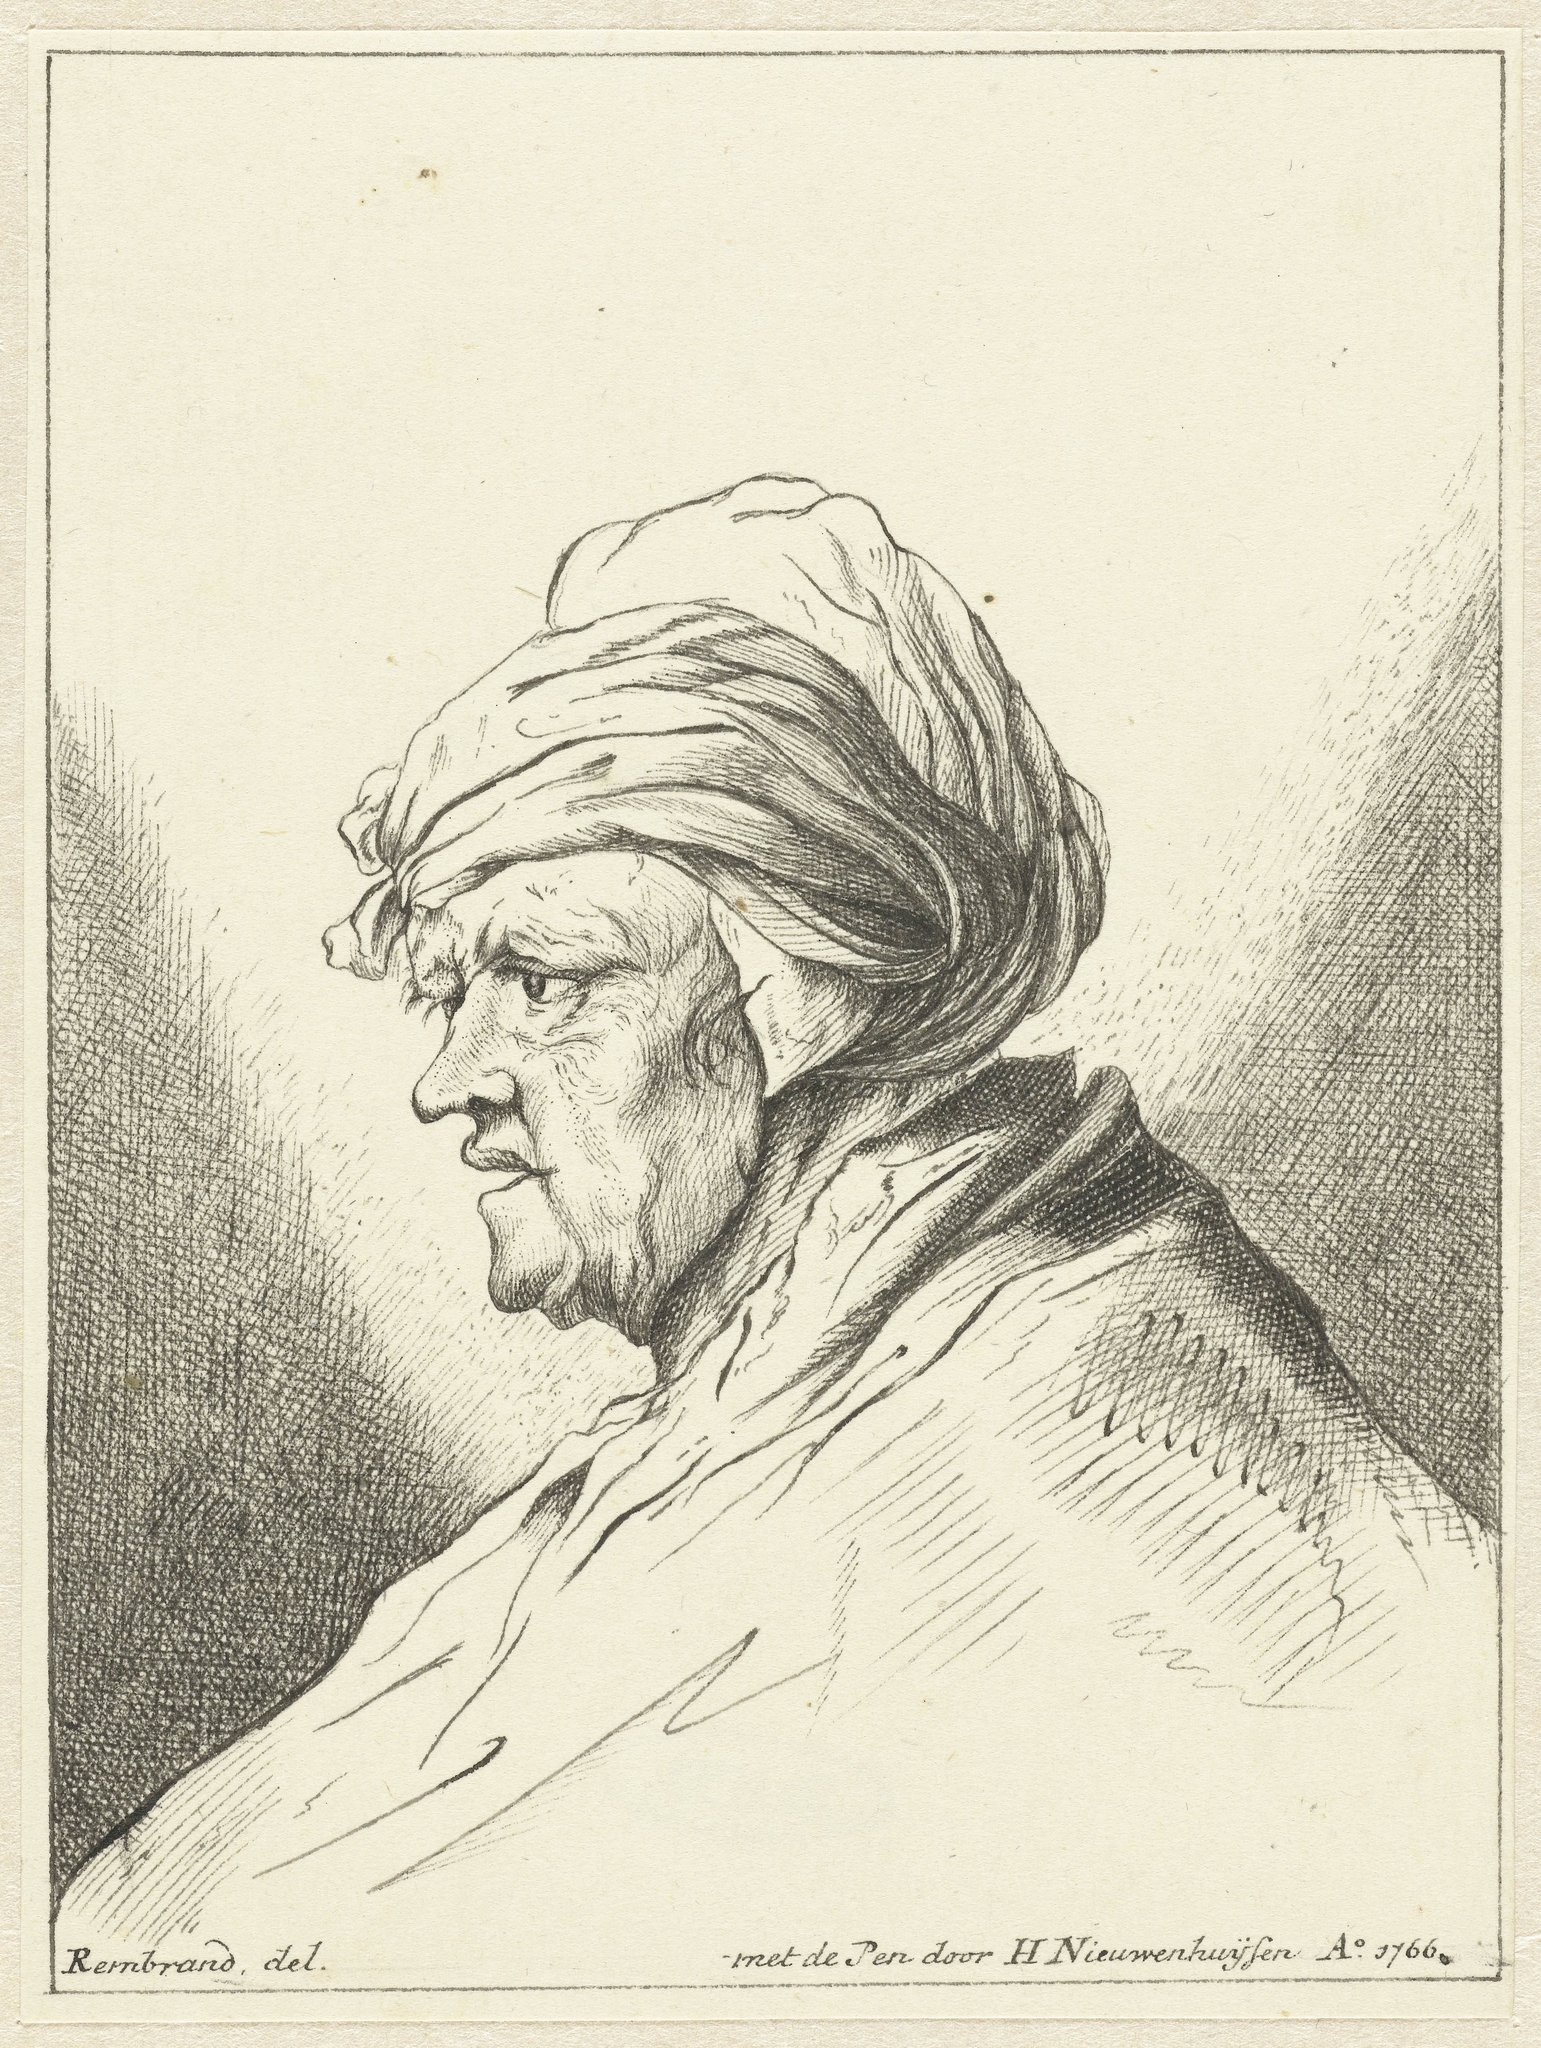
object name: drawing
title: Buste van oude vrouw, naar links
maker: hendrik nieuwenhuysen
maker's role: draughtsman, print maker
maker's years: 1747-1794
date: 1766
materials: ink, paper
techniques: pen